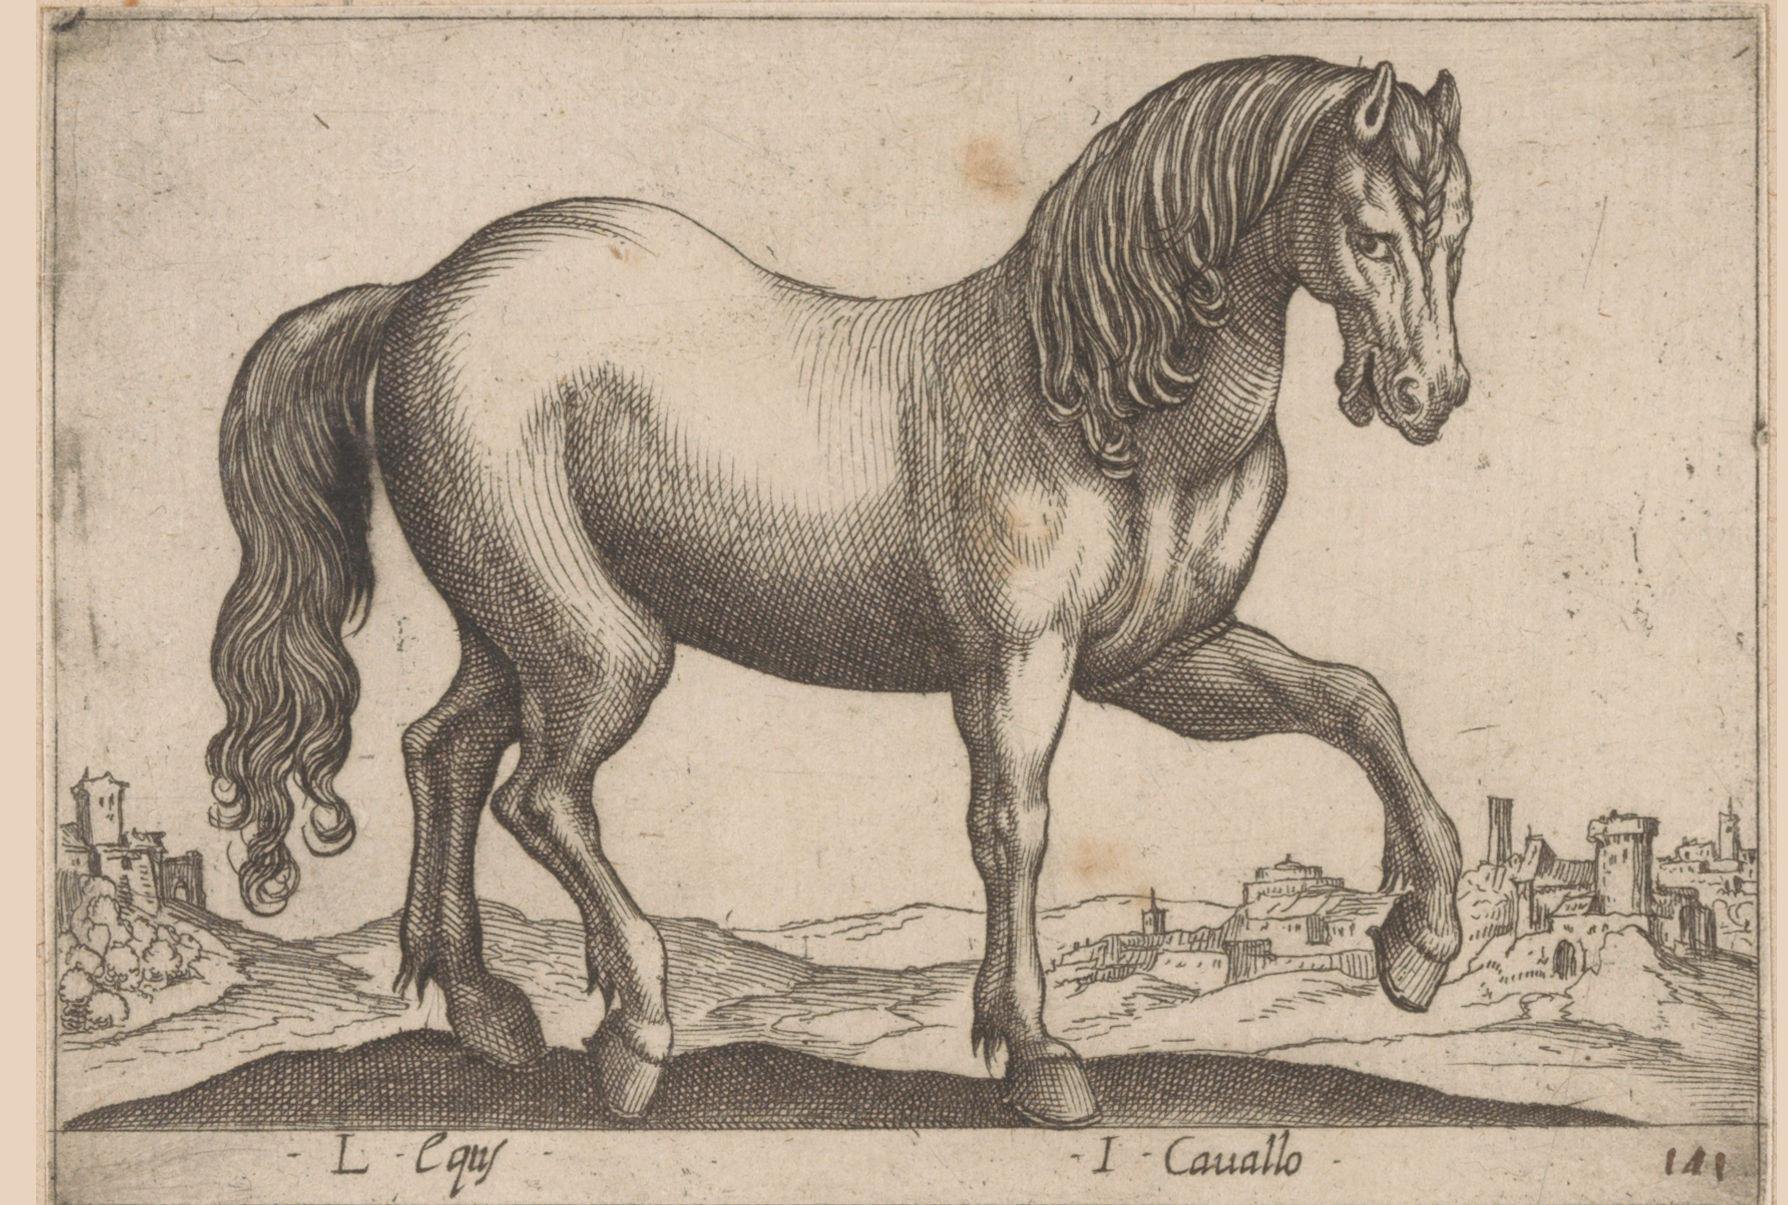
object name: print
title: Nova raccolta de li animali piu curiosi del mondo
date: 1565-1630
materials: paper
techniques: etching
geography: rome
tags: horses and kindred animals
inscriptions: collector's mark: Lugt 11, number: ‘141’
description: Deze prent maakt deel uit van een reeks prenten van dieren door Antonio Tempesta. Bekend is dat een tweede staat (met nummering) van deze serie is uitgegeven door Giovanni Giacomo de' Rossi in 1650. Onbekend is wie de eerste staat heeft uitgegeven en wanneer.